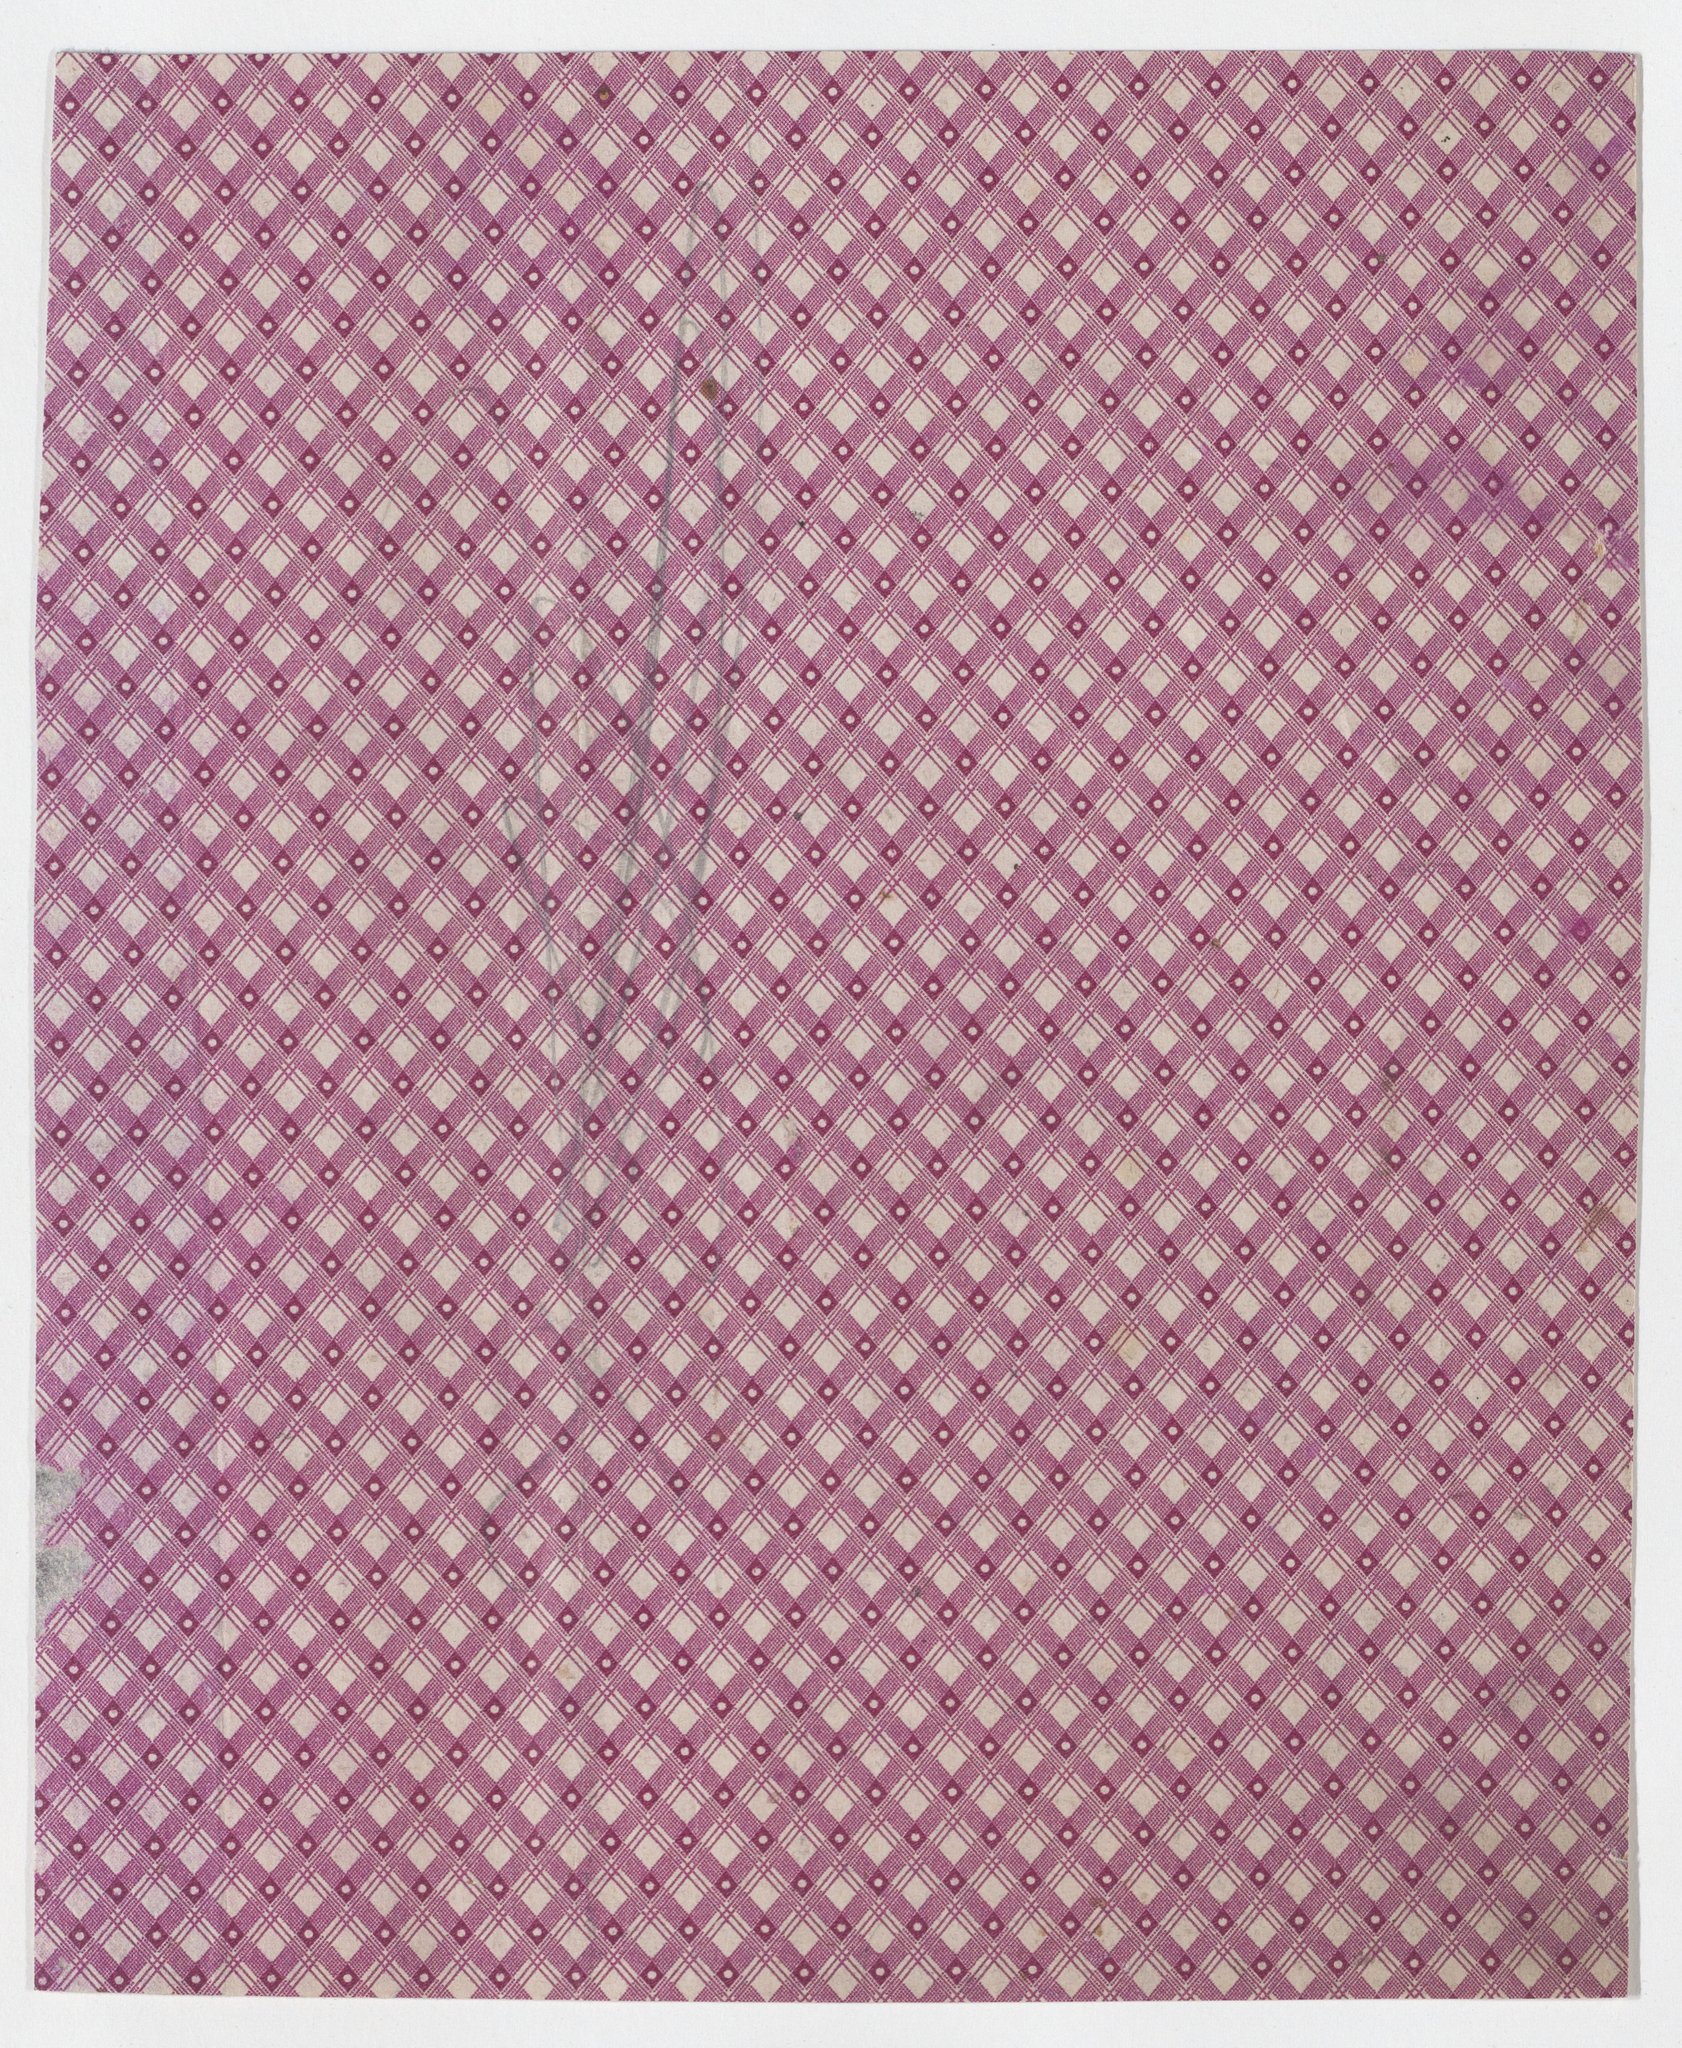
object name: print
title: Sheet with crisscross pattern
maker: Anonymous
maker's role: artist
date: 1801-1900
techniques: relief print